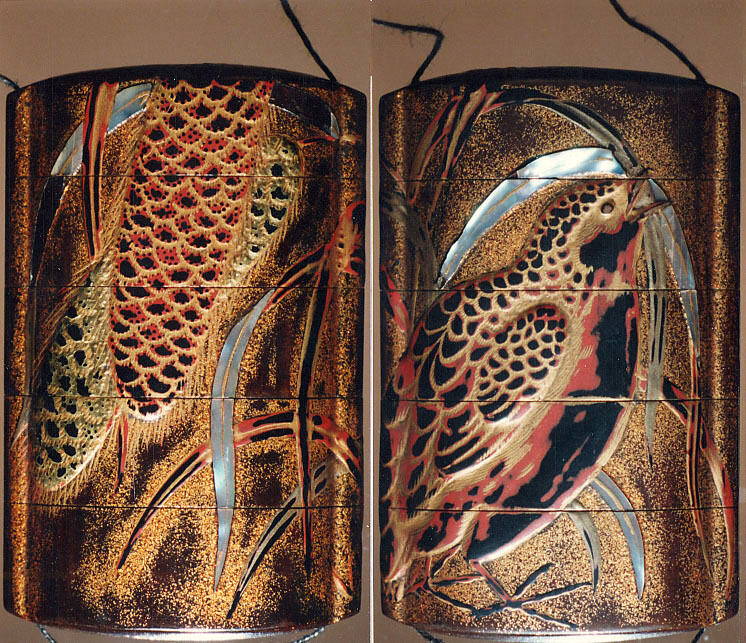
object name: inrō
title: Case (Inrō) with Design of Quail Standing beside Millet Stalks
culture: japanese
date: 1734-1766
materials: gold, lacquer, metal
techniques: fundame, hiramakie, roiro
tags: birds,plants